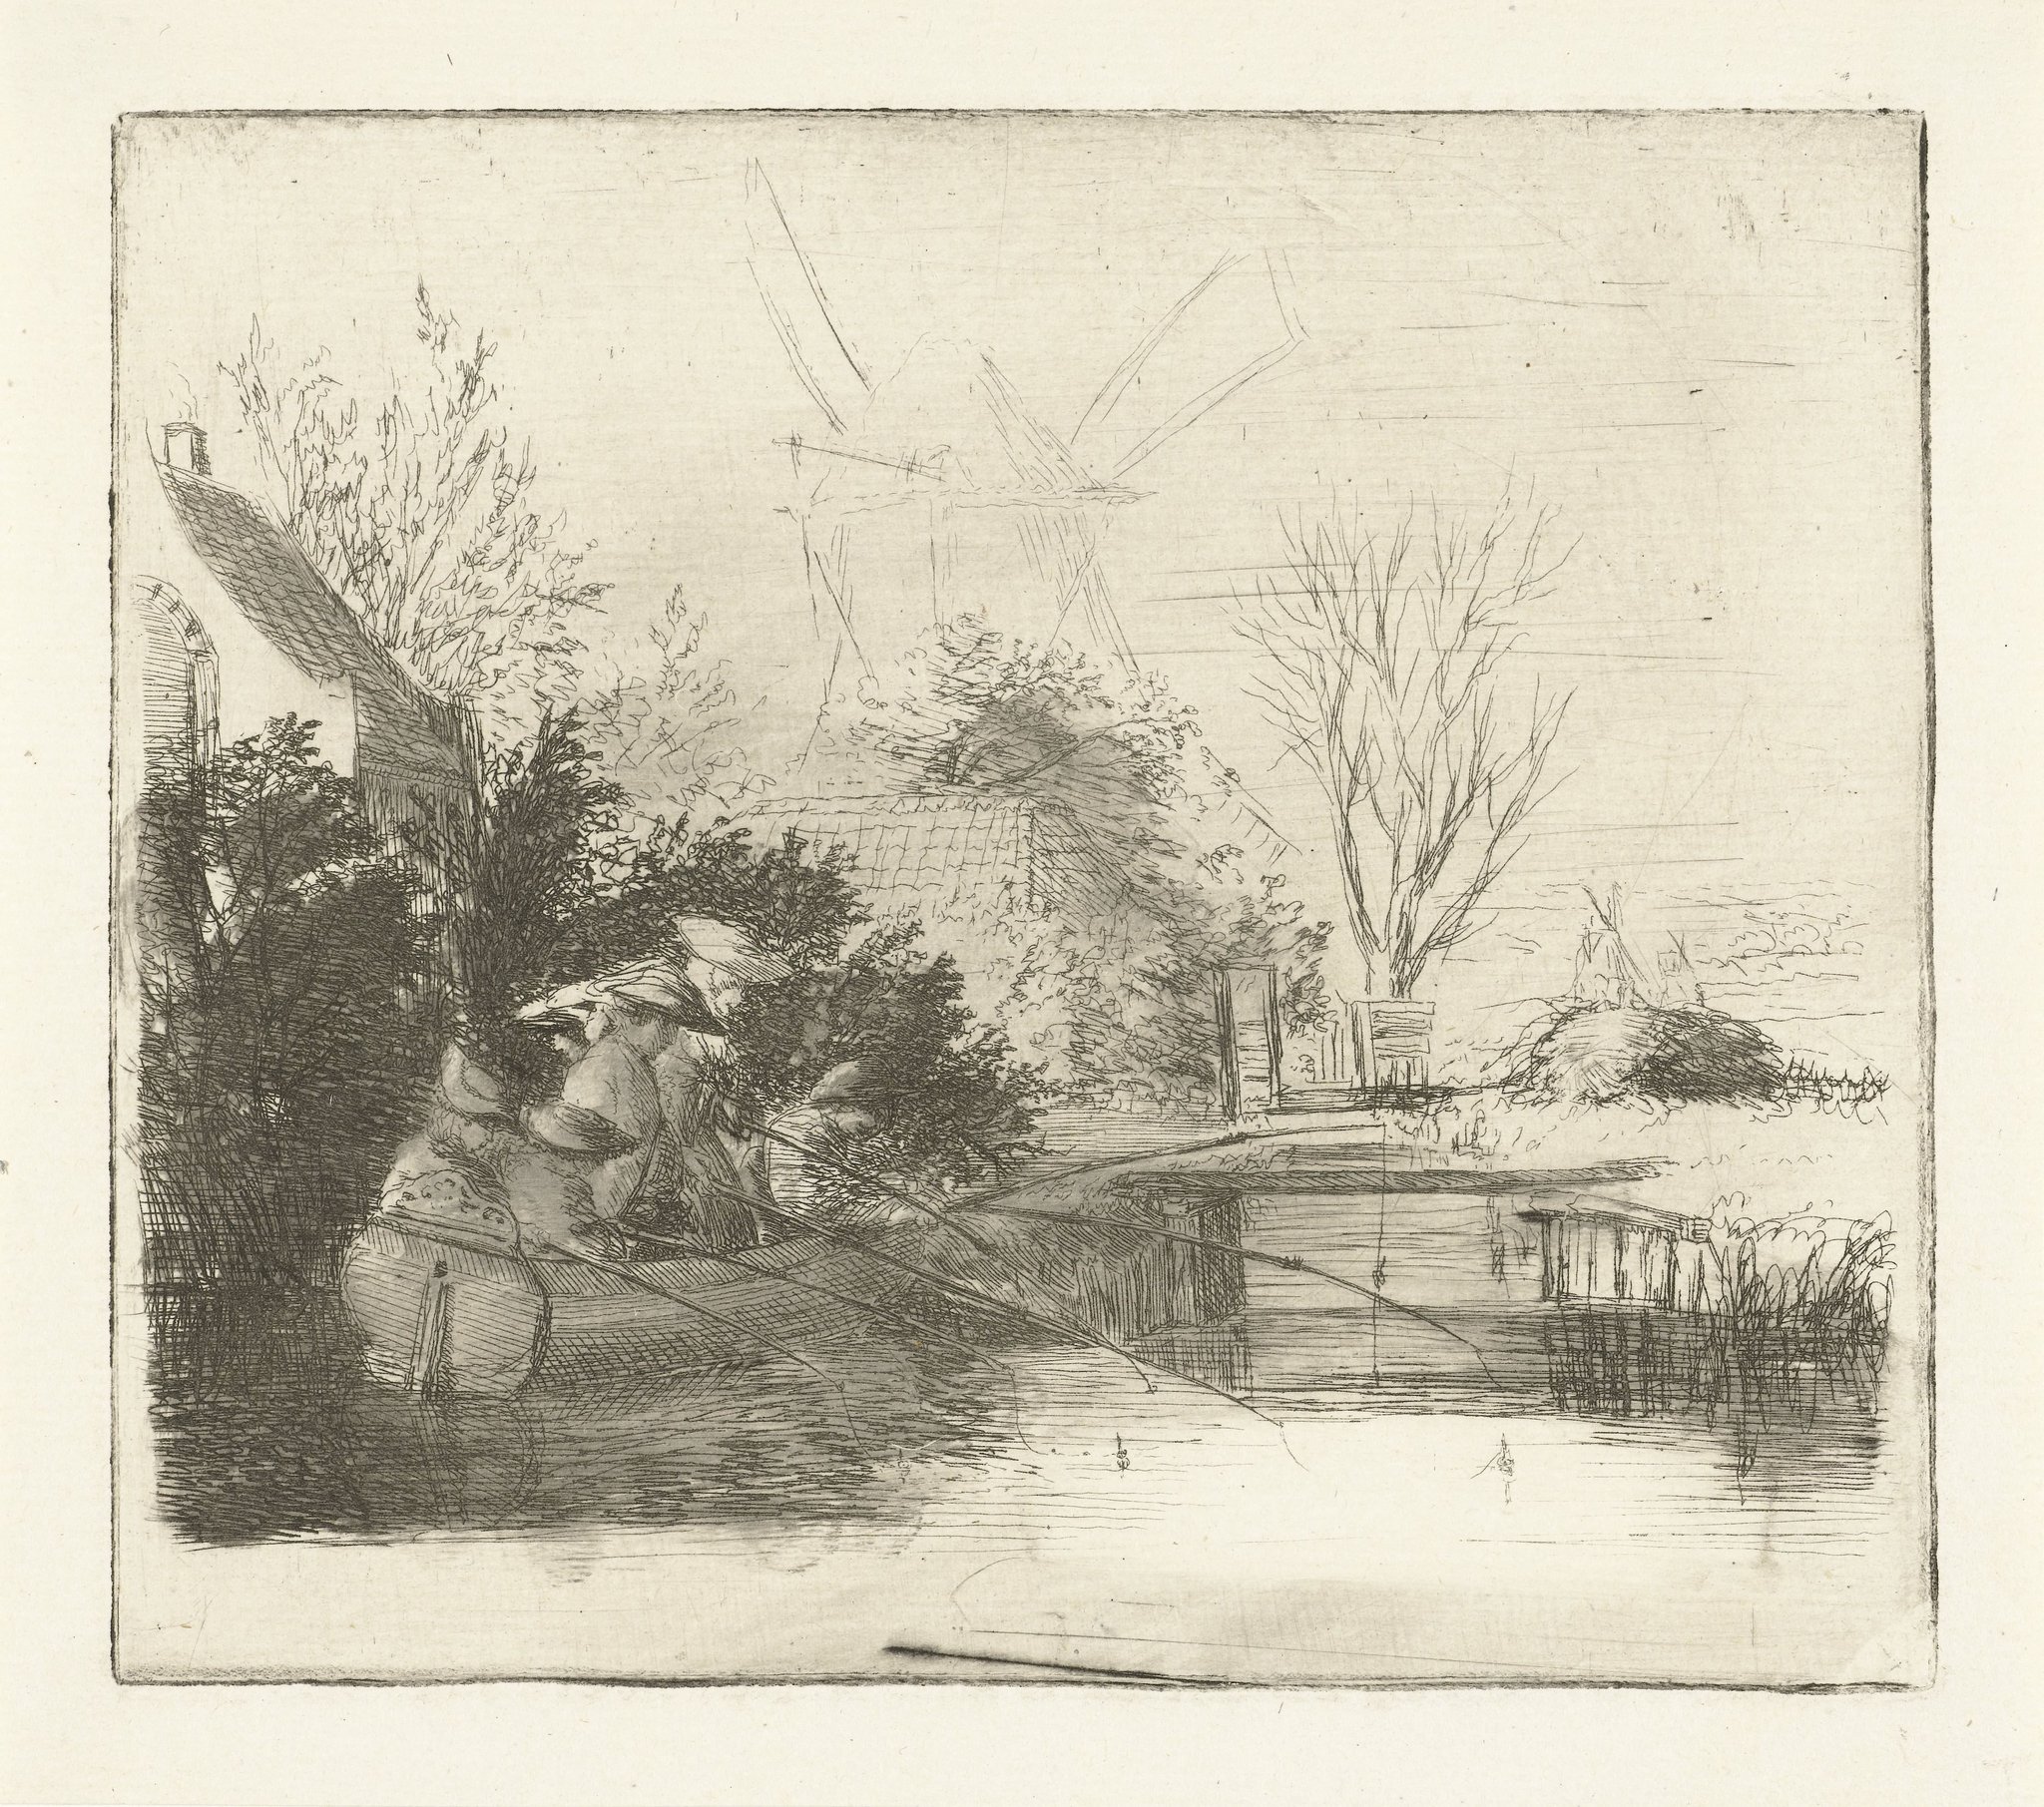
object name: print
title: Hengelaars bij een rivier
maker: louis bernard coclers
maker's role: draughtsman, print maker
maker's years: 1741-1817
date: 1756-1817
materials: paper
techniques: drypoint, etching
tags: fresh-water fishery, rowing-boat, canoe, etc.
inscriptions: collector's mark: Lugt 2228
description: Een groepje mannen vist vanuit een bootje in een rivier. Op de achtergrond een brug en de omtrek van een molen.